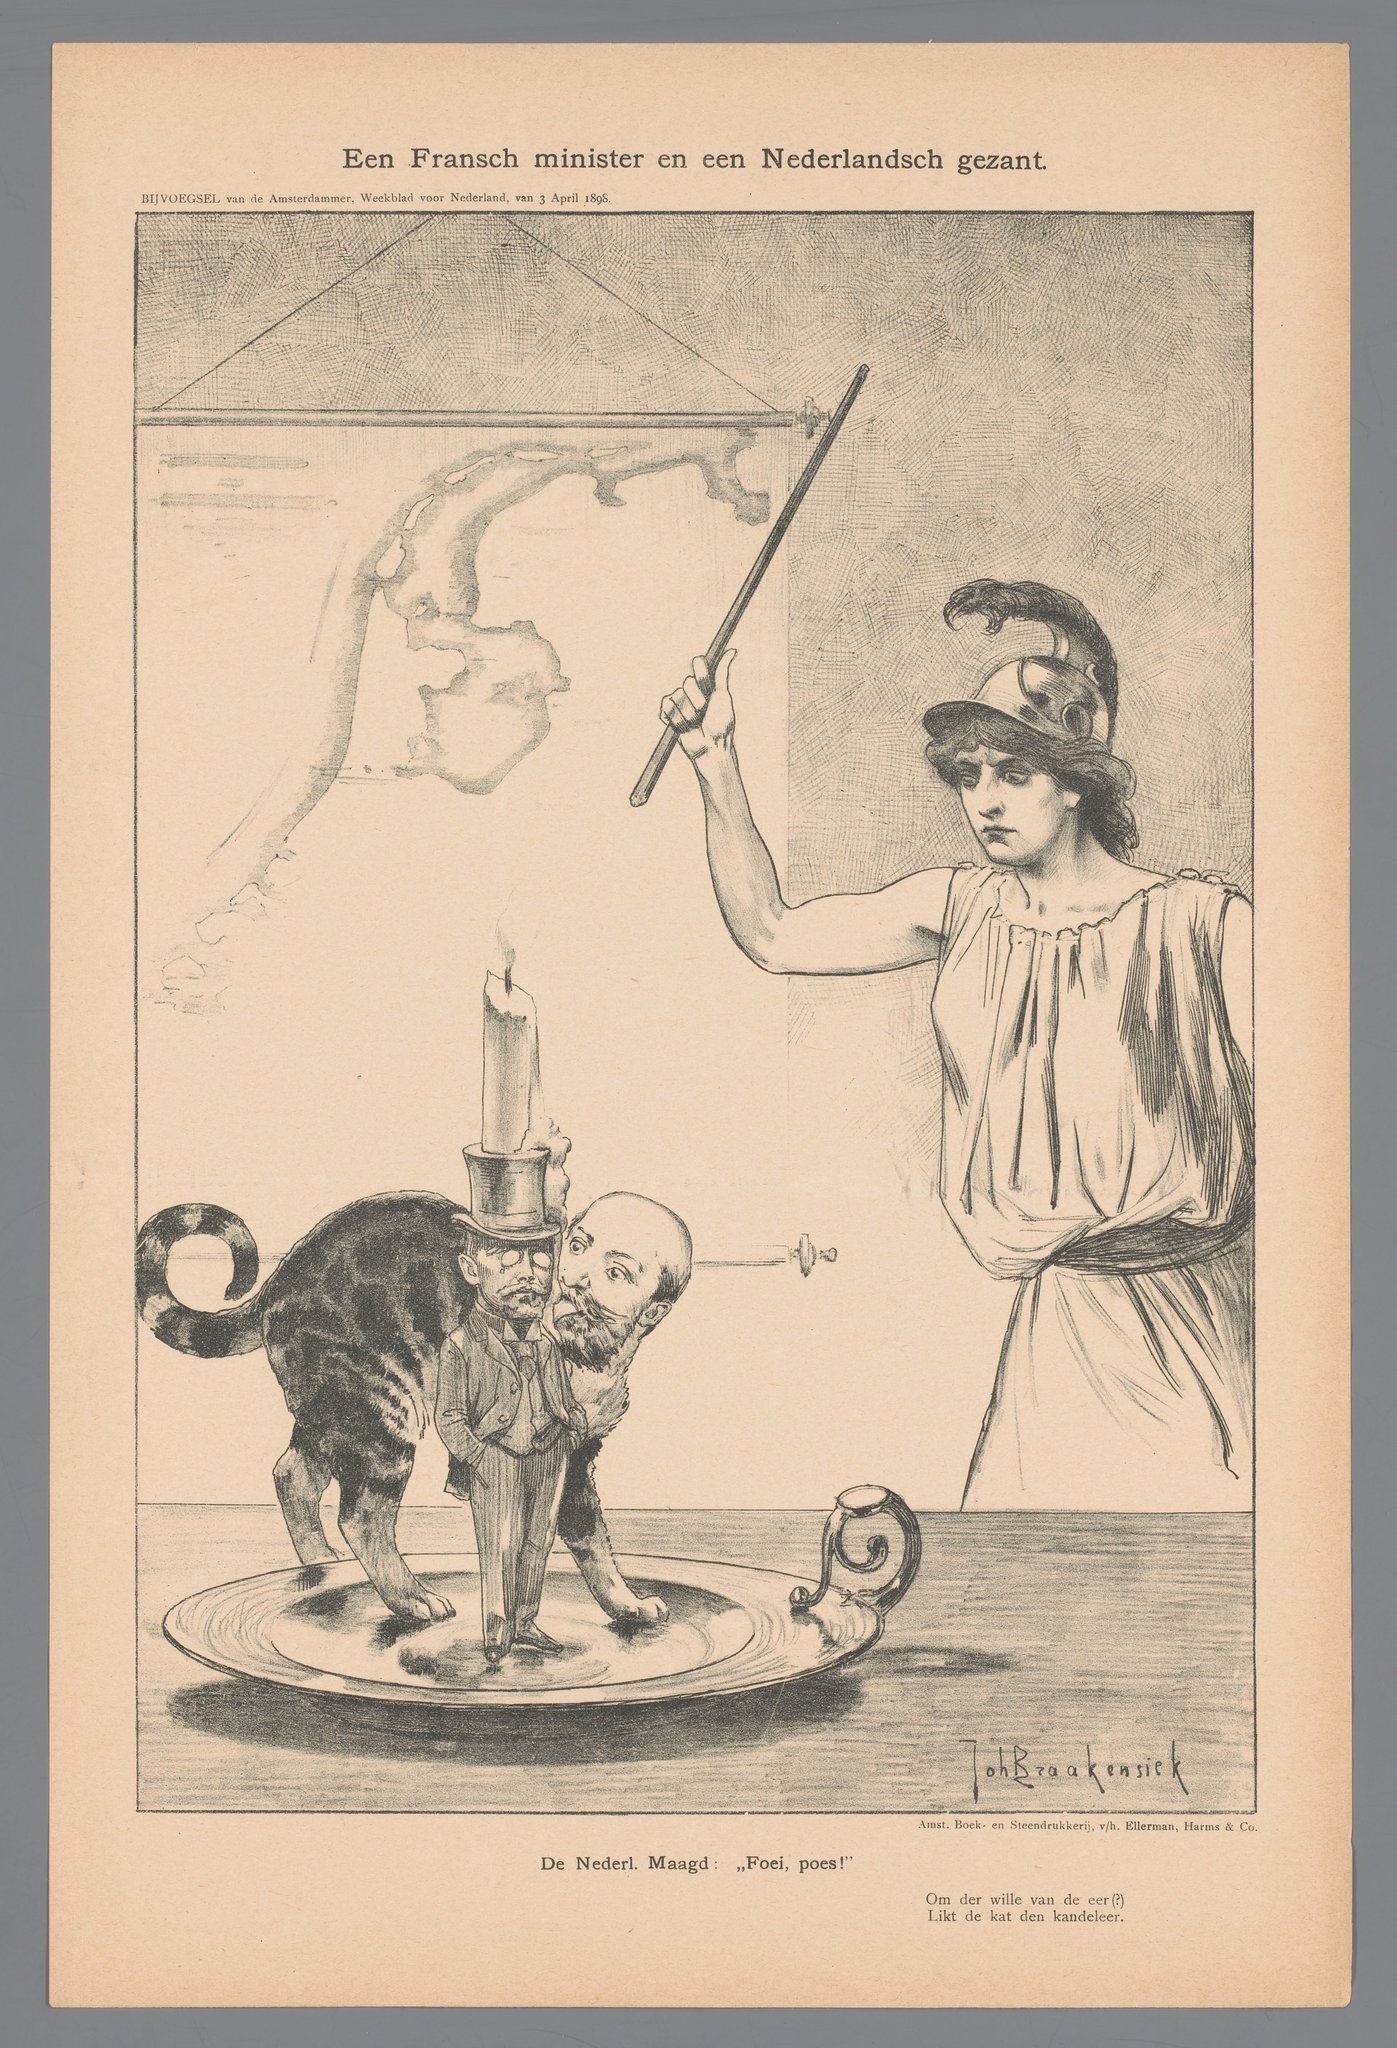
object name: cartoon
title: Een Fransch minister en een Nederlandsch gezant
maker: johan braakensiek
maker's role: draughtsman, print maker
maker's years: 1858-1940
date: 1898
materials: paper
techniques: lithograph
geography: amsterdam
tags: politician, maps of separate countries or regions, cat, candle, personifications of countries, nations, states, districts, etc. (+ nation; national), political caricatures and satires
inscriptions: date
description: Prent uit het bijvoegsel van: De Amsterdammer. Weekblad voor Nederland, 3 april 1898.